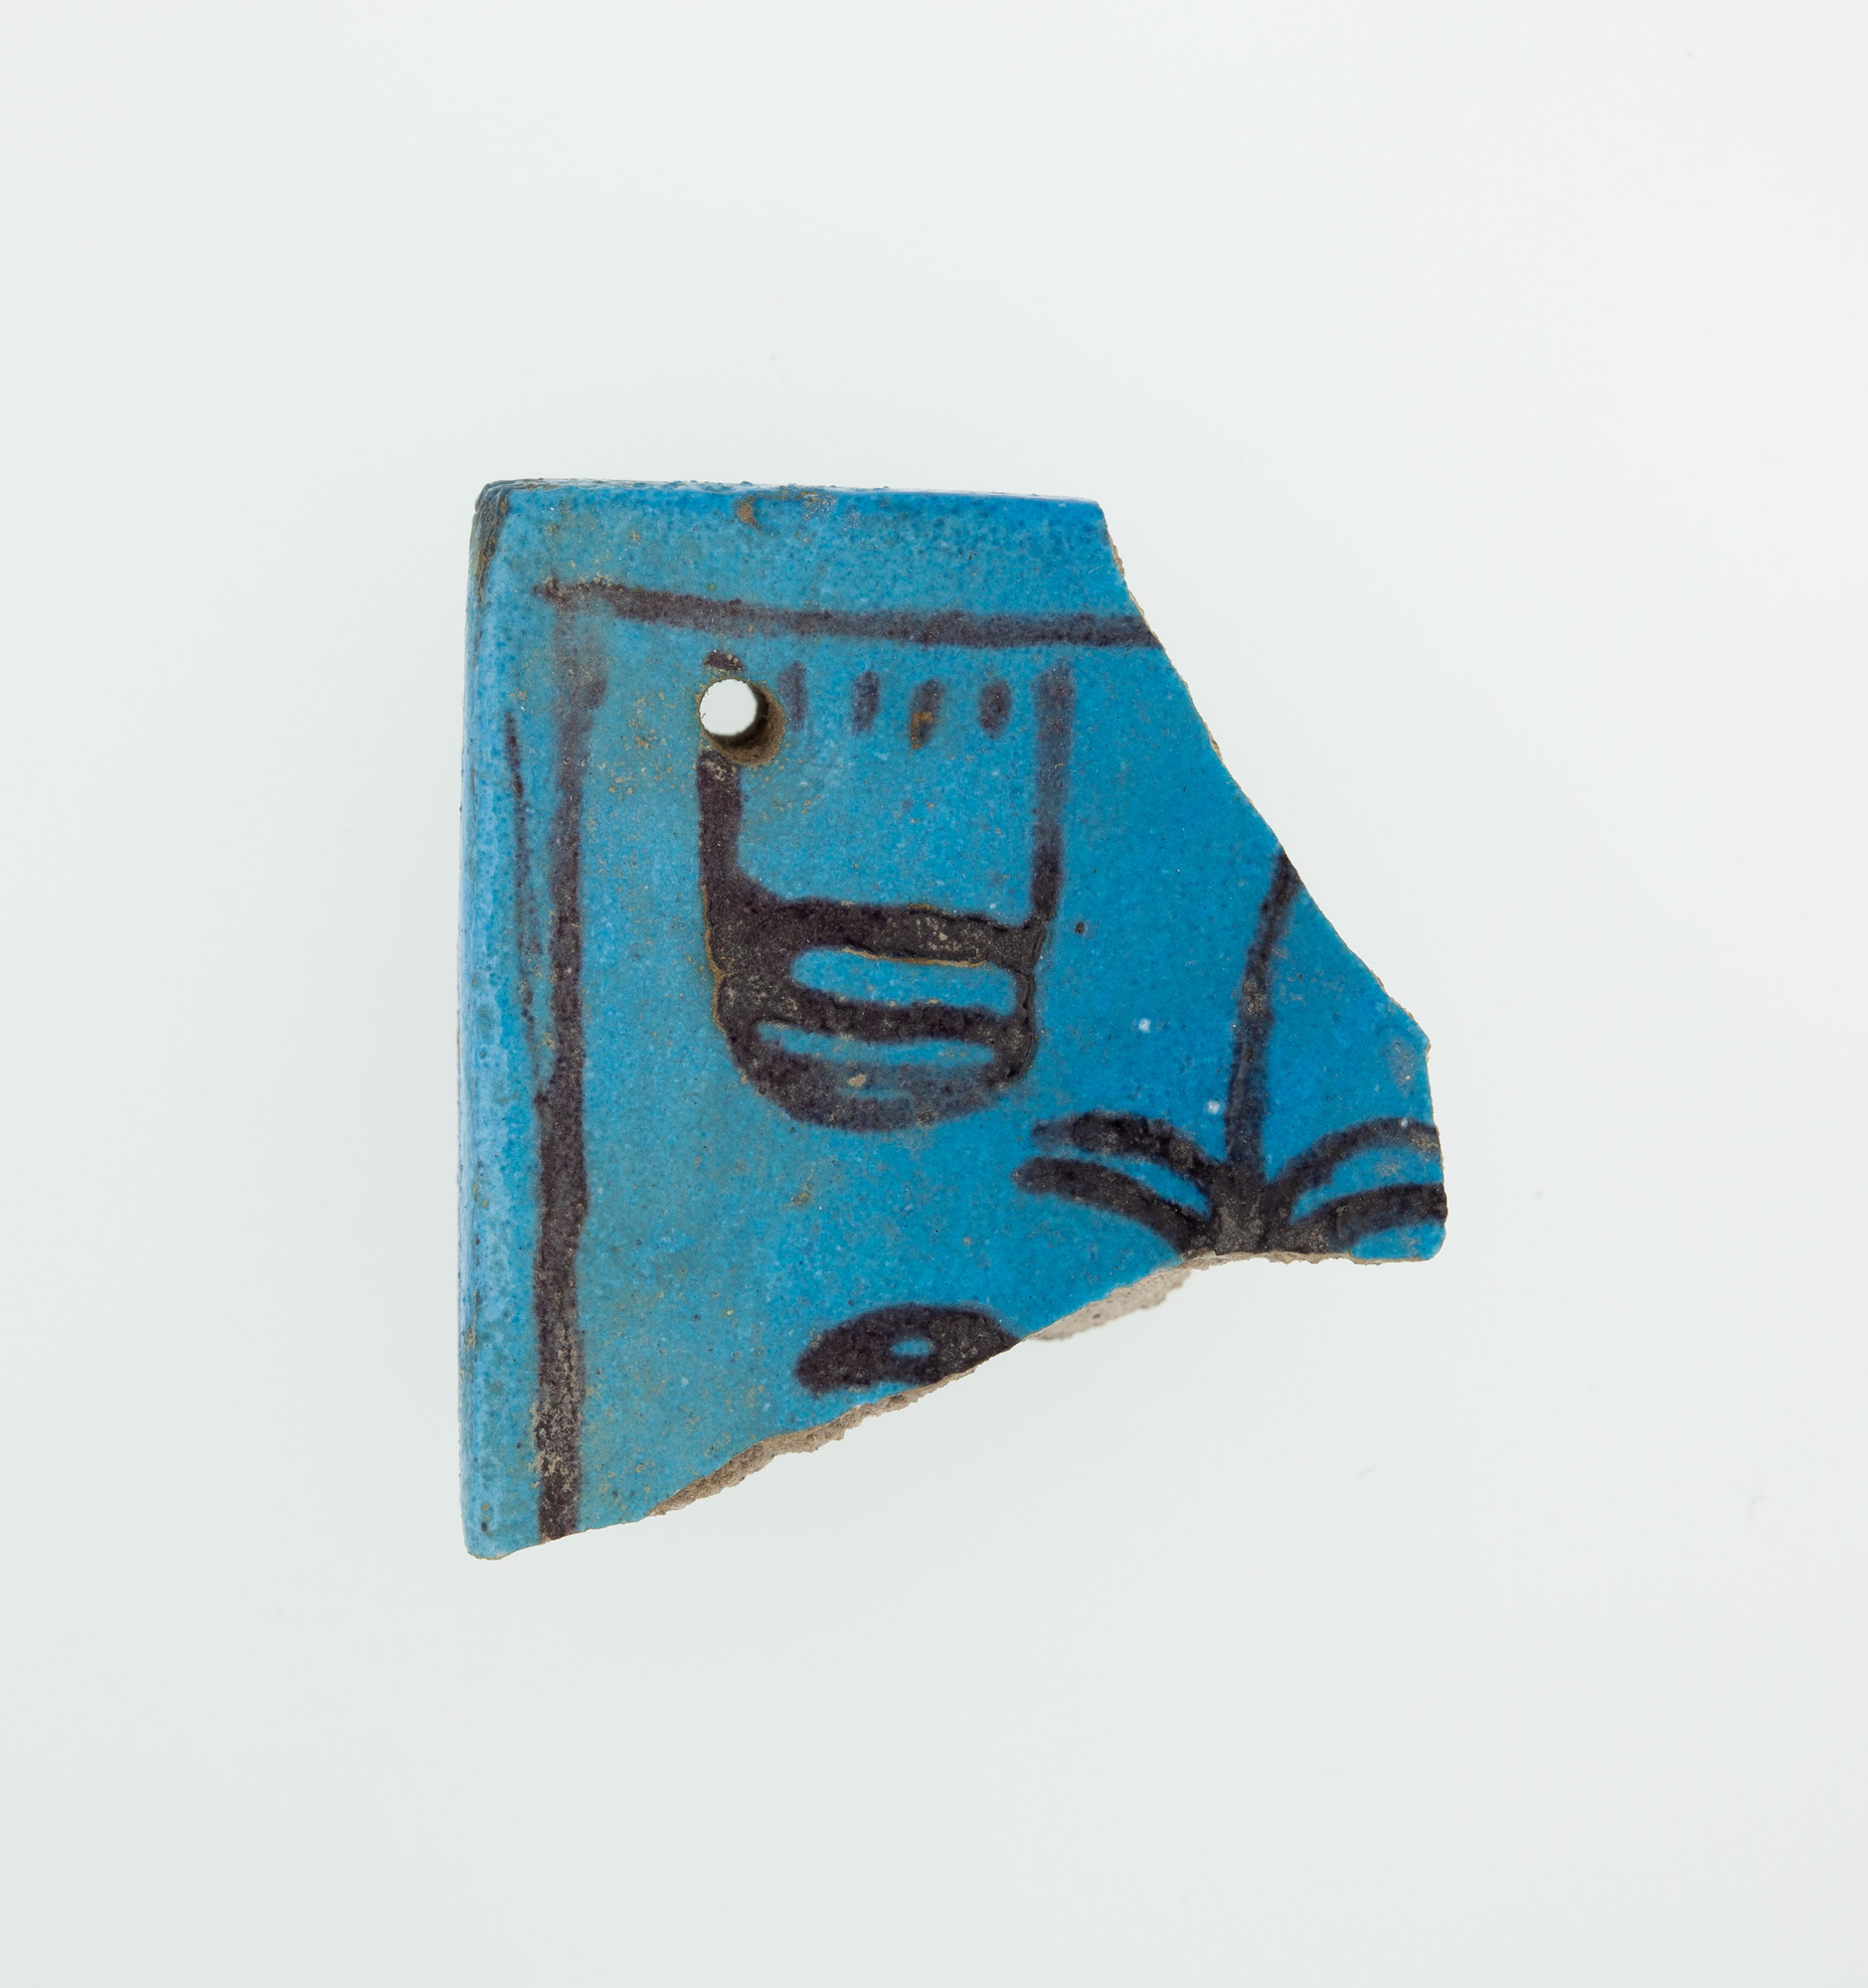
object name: menat fragment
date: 1479-1458 BCE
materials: faience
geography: egypt